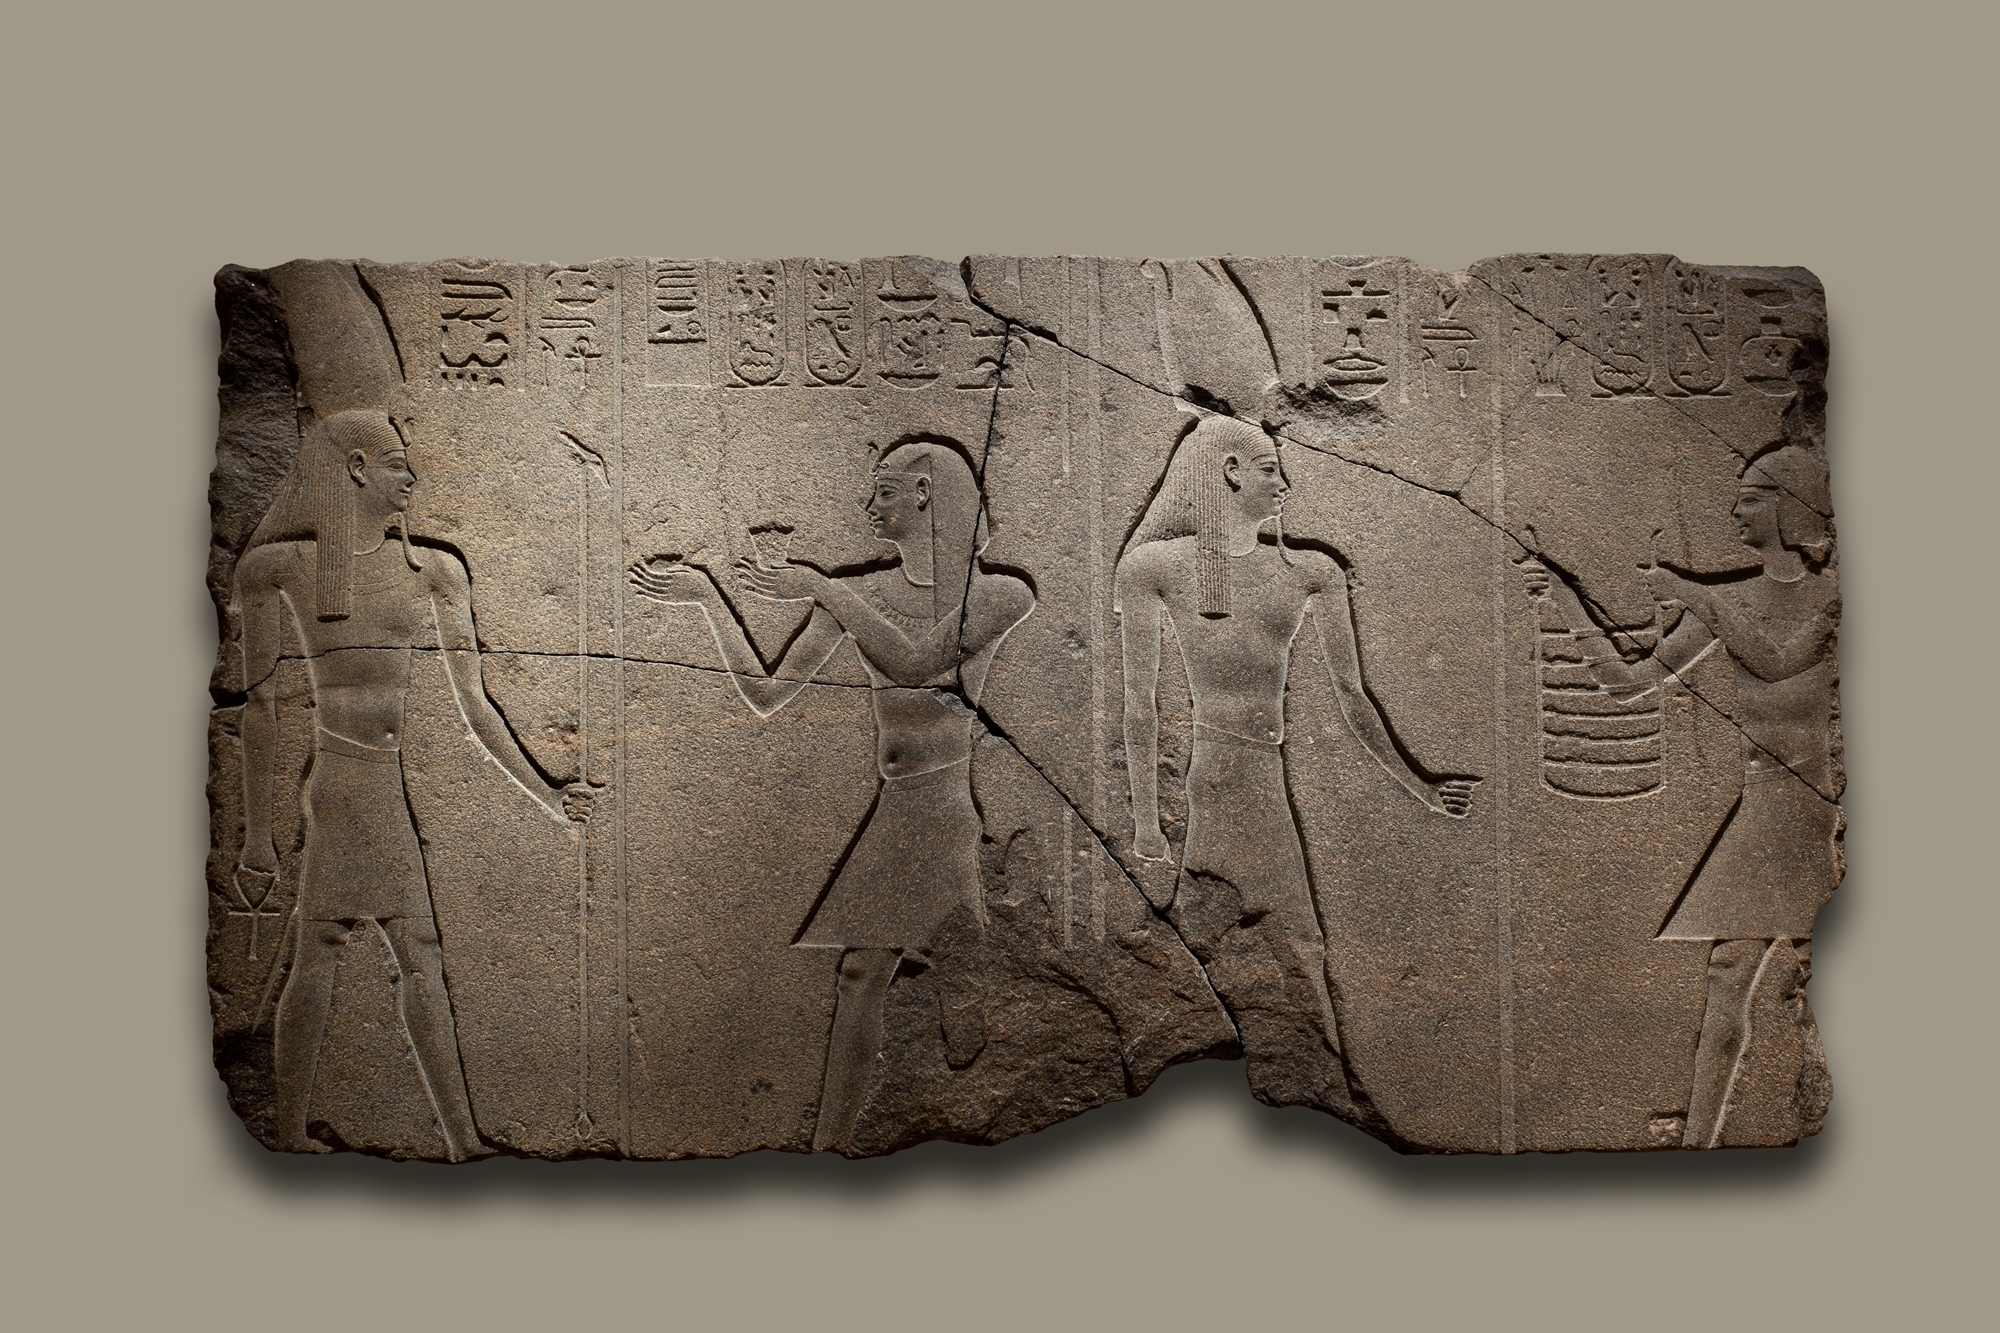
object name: relief, nectanebo ii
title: Nectanebo II Offers to Osiris Hemag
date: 360-343 BCE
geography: egypt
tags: men,hieroglyphs